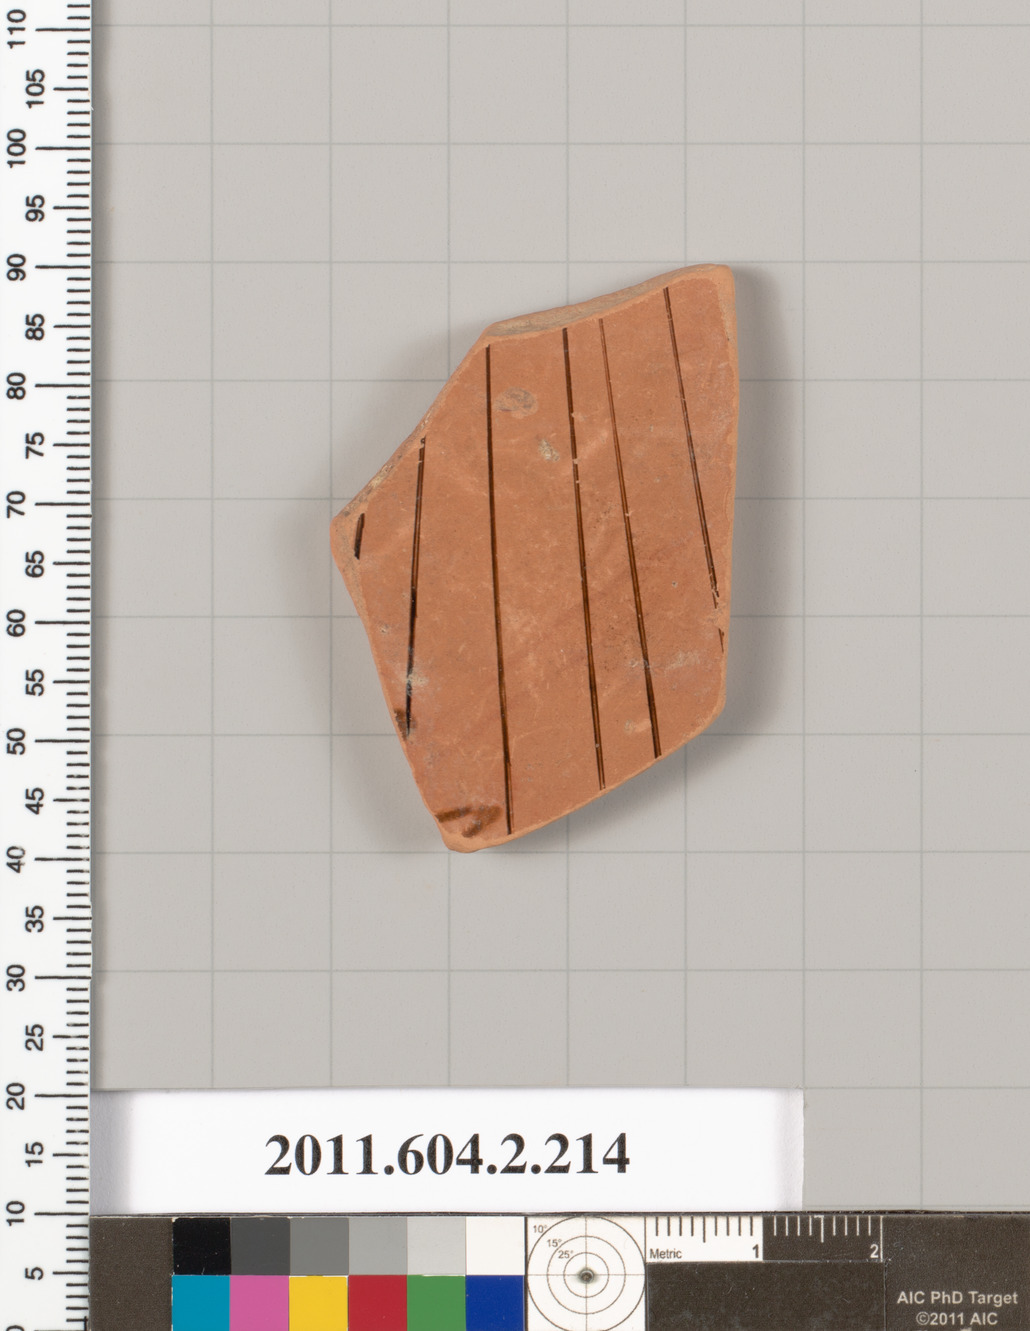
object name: stamnos fragment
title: Terracotta fragment of a stamnos (jar)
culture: greek, attic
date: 450-440 BCE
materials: terracotta